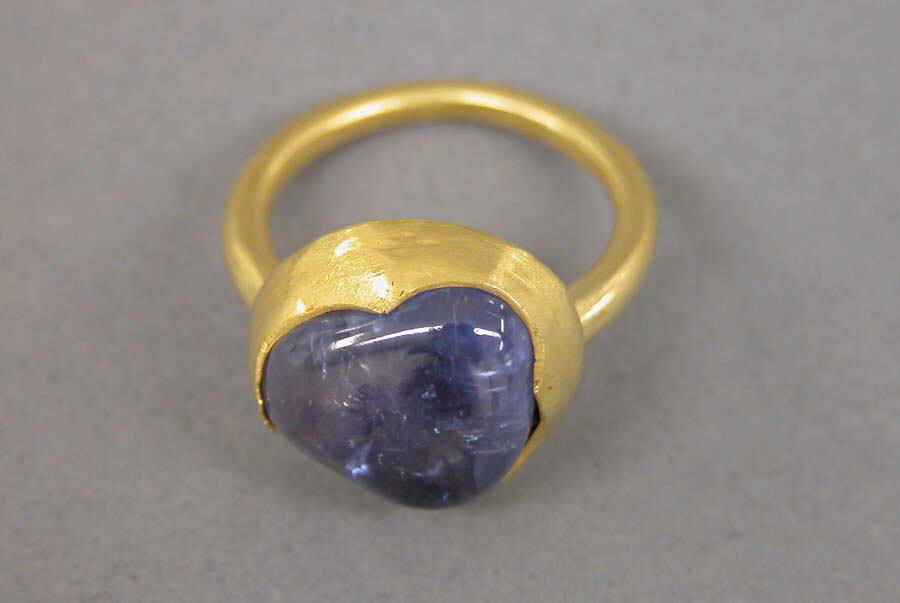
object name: ring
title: Ring with Inset Blue Stone in Circular Mount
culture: indonesian, javanese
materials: gold, stone